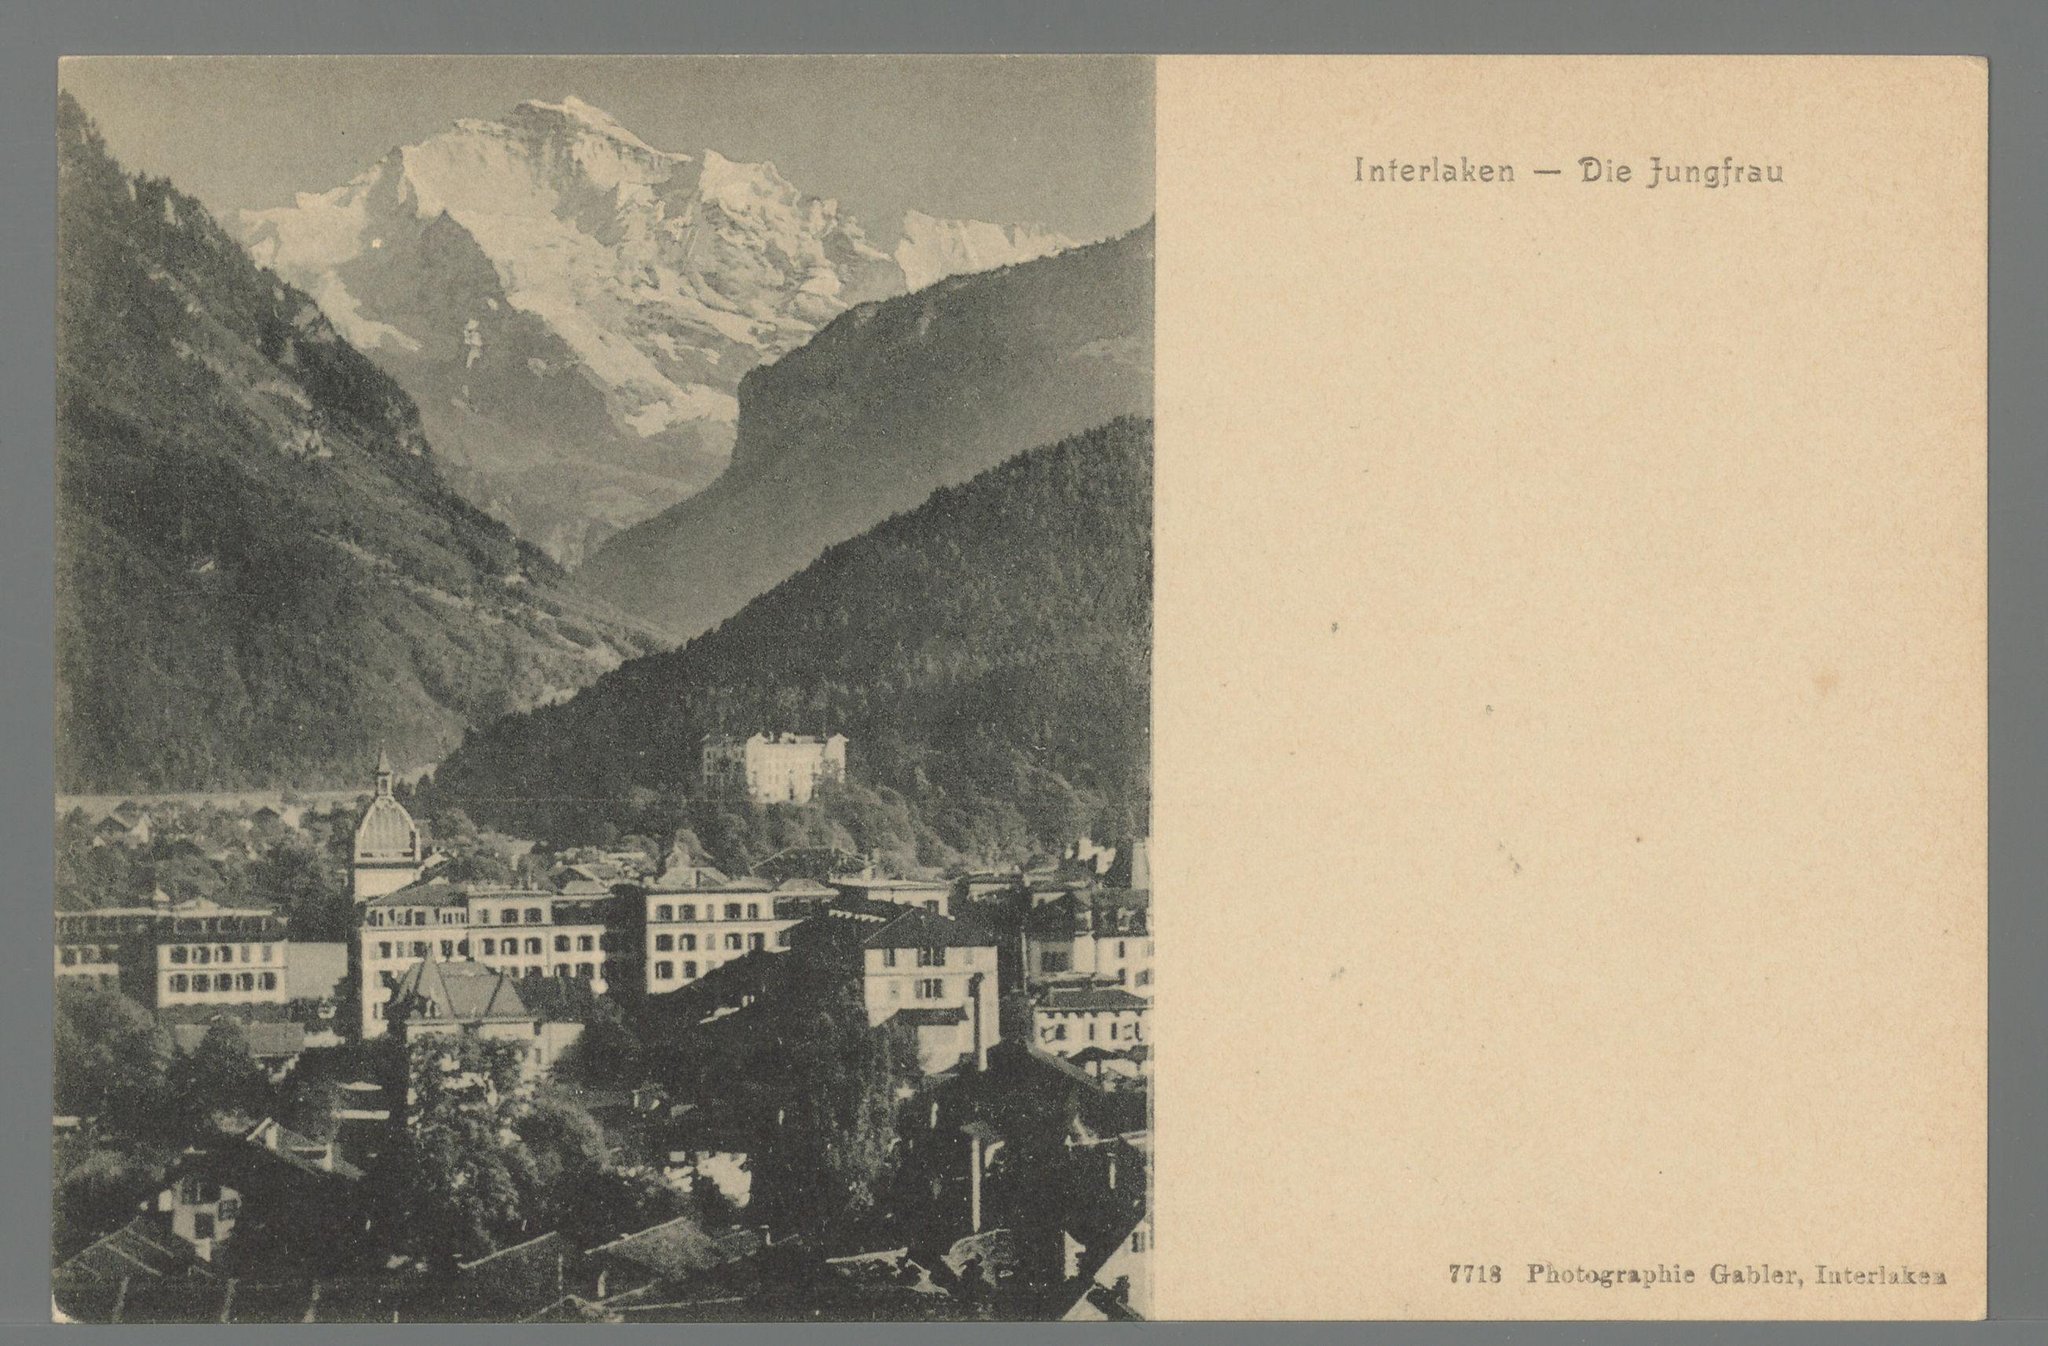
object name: photomechanical print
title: Interlaken. Die Jungfrau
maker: Anonymous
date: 1890-1905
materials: cardboard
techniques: photograph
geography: interlaken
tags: mountain-range, snow peaks, prospect of city, town panorama, silhouette of city